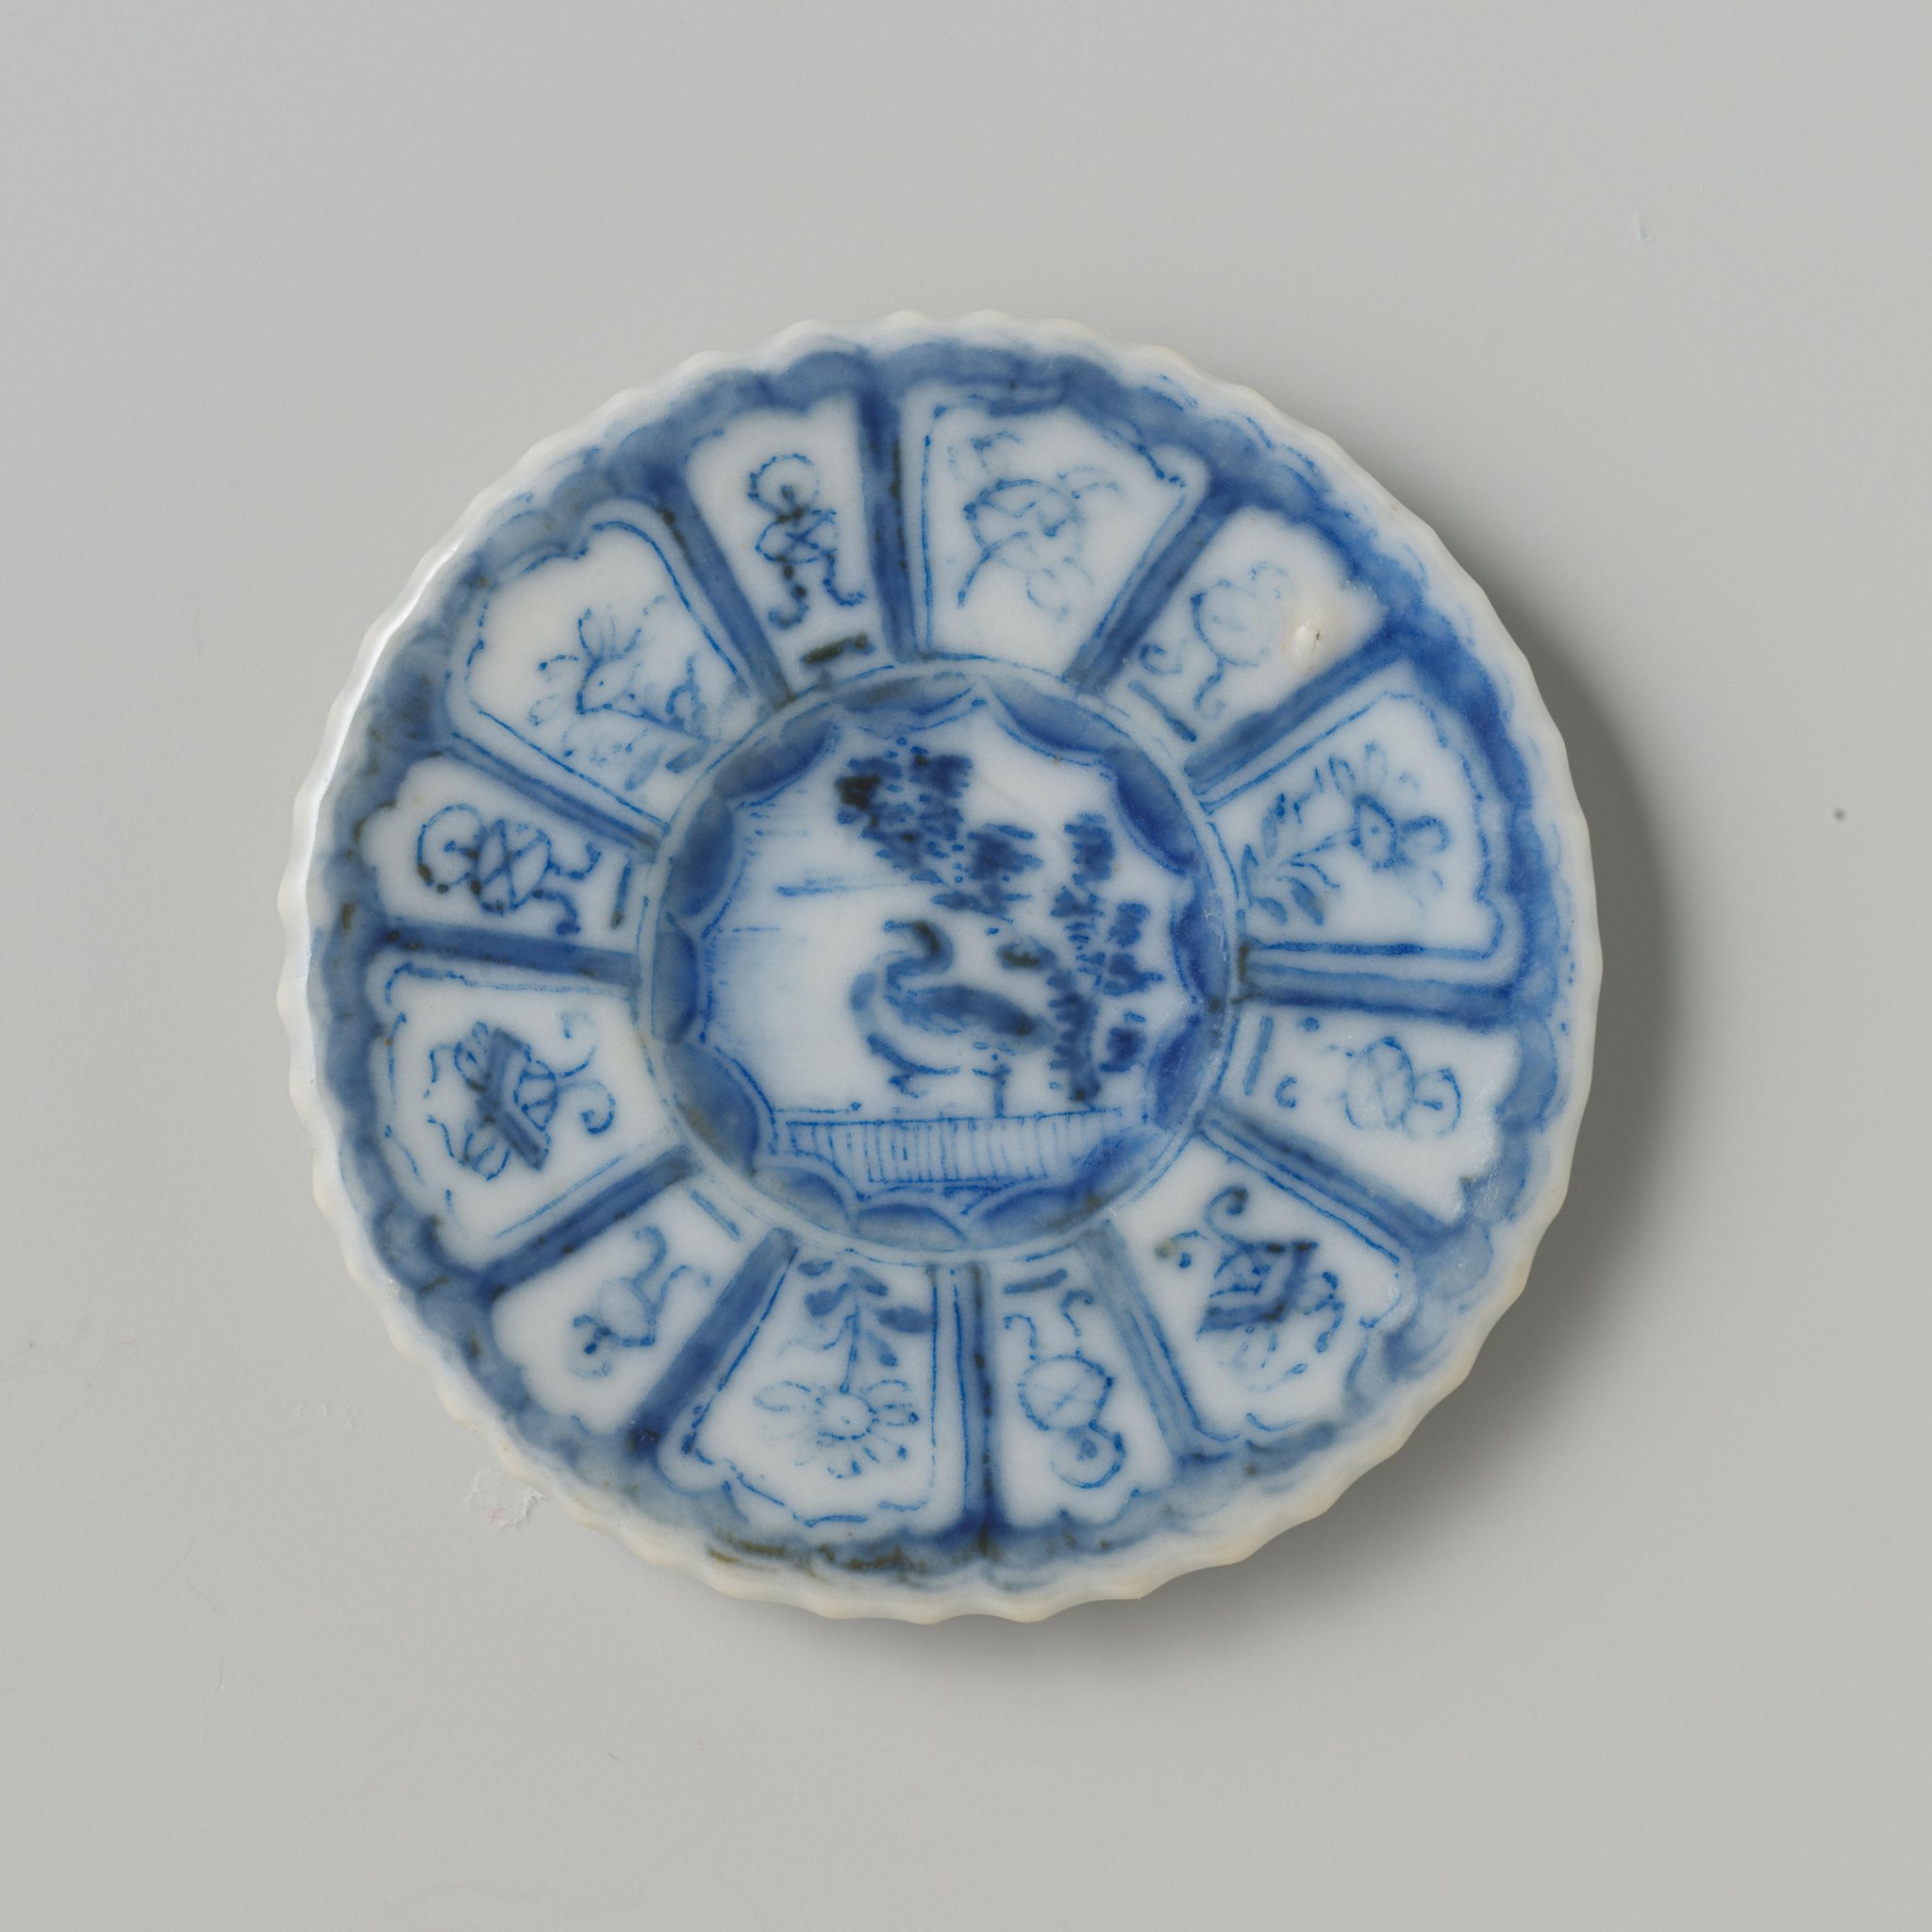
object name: plate dish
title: Plate with a bird in a landscape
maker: Anonymous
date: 1690-1710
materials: cobalt, glaze, paint, porcelain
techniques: firing, turning, vitrification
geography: china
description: Eén van 12 borden van porselein en steatite met blauwe onderglazuur, decoratie in 'Kraakporselein' of Wanli stijl: plat met vogel (eend) onder boom aan oever, rand in vakken met strikwerk, bloemen en symbolen, geribbelde rand. Bordje eveneens op achterzijde versierd, rand in vakken met bloemen.